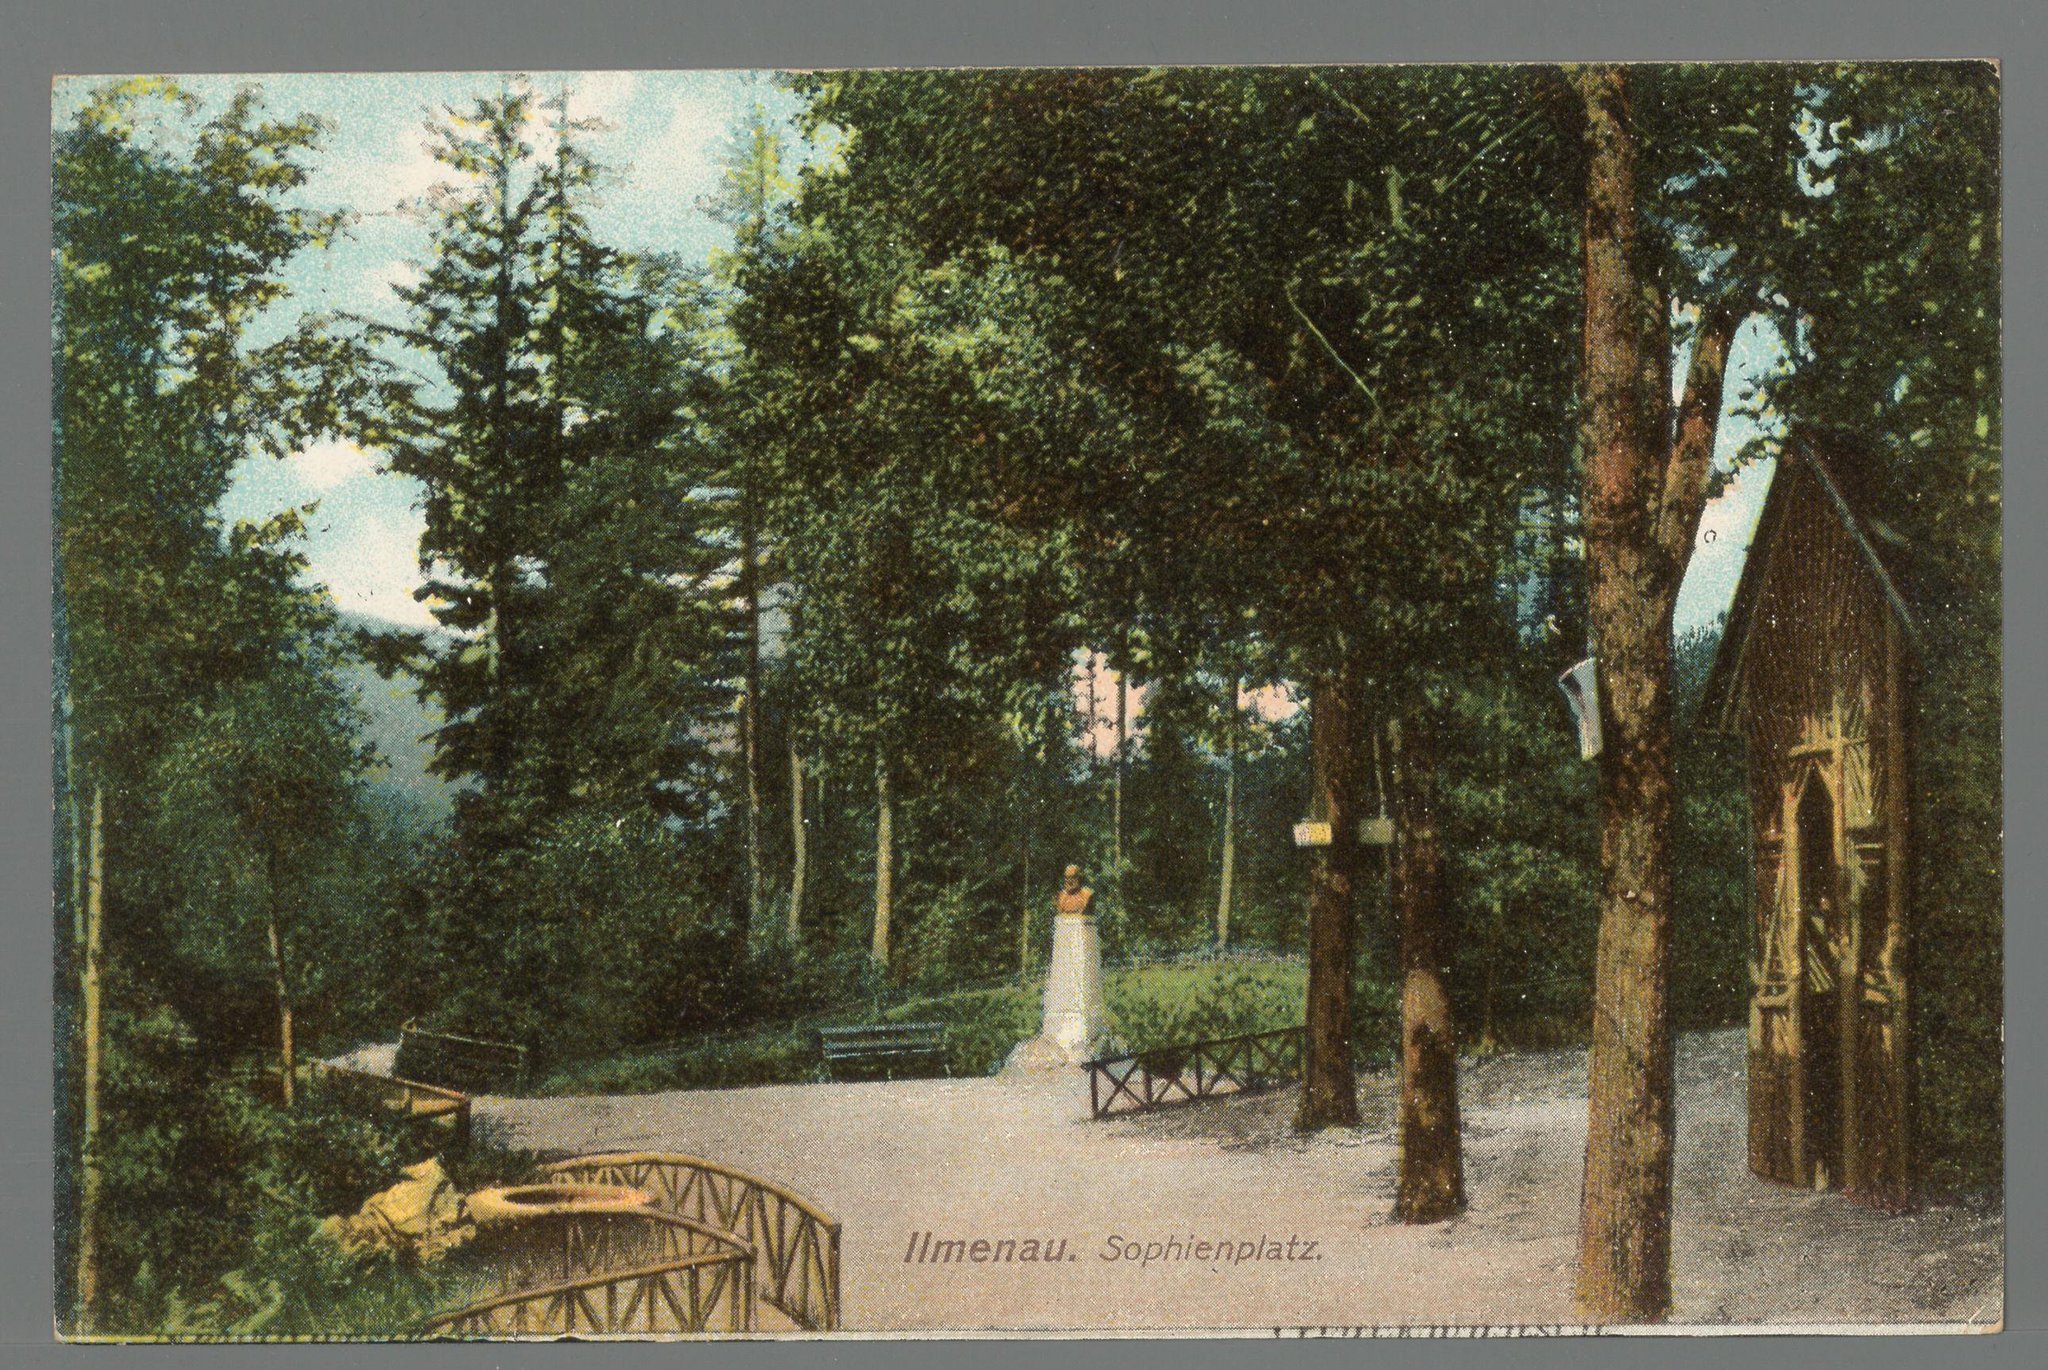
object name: ansichtkaart, prentbriefkaart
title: Ilmenau. Sophienplatz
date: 1905-1930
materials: cardboard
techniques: lithograph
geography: munich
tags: mountains